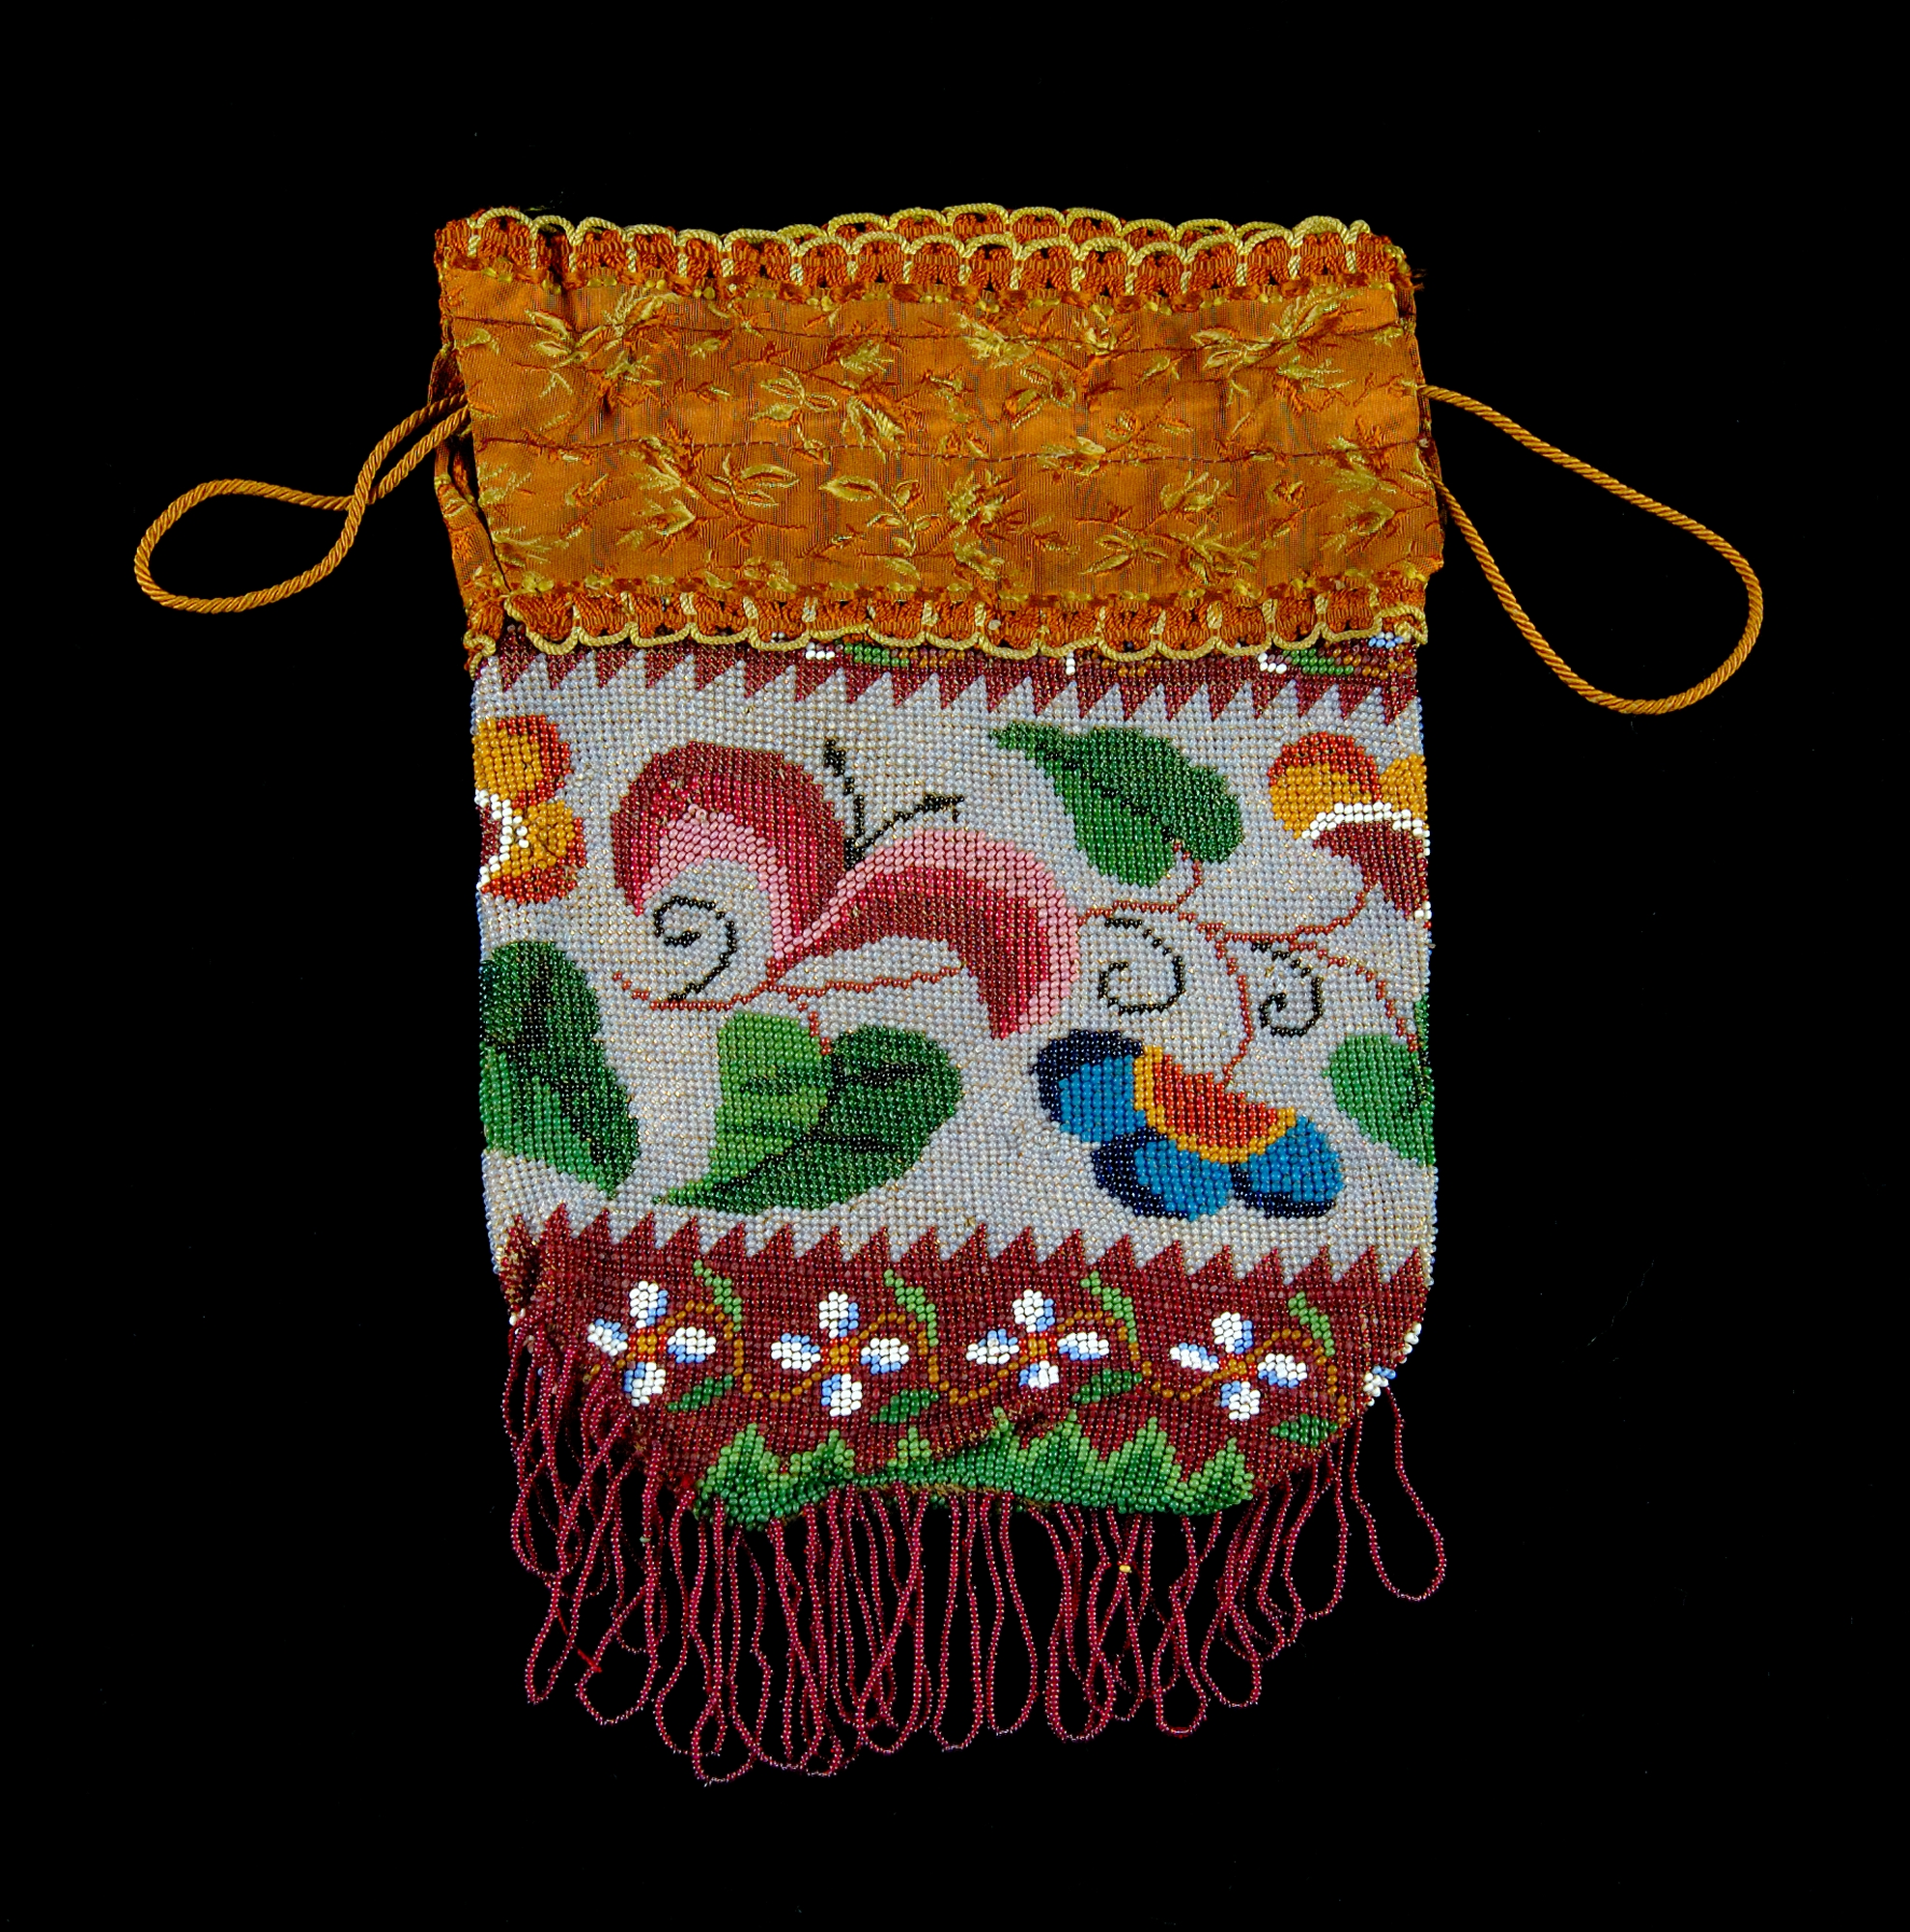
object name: pouch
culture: american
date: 1876-1900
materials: glass, linen, silk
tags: flowers